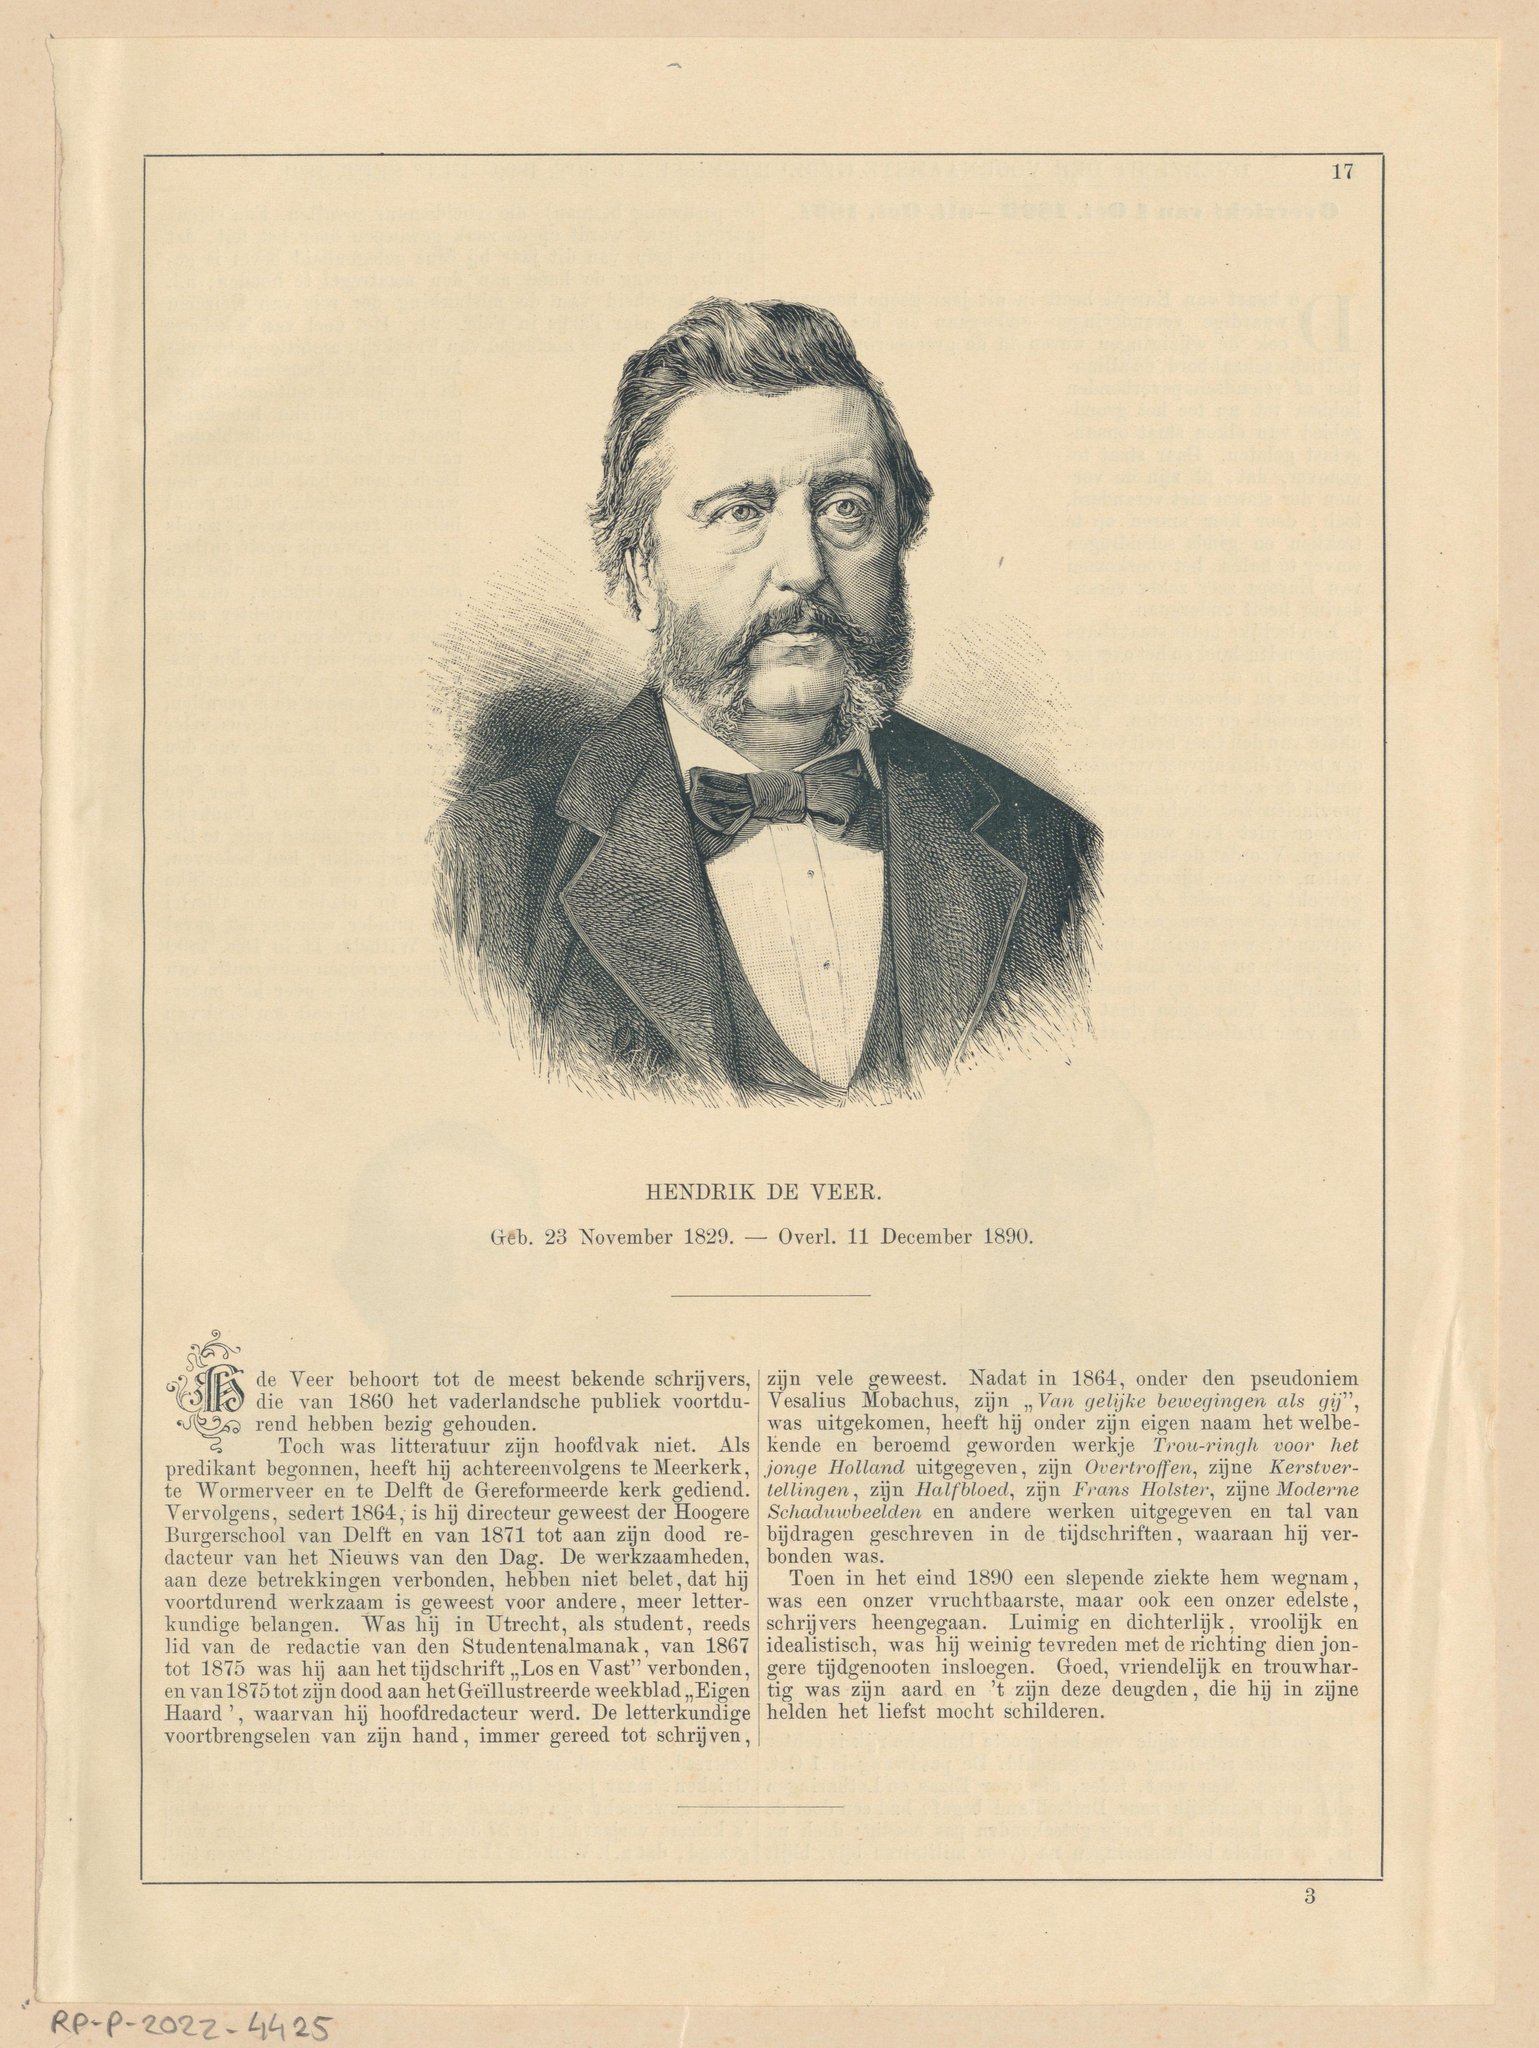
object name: print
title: Portret van Hendrik de Veer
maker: Anonymous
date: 1892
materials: paper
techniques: letterpress printing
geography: haarlem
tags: rhenen, historical persons, portrait of a writer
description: Prent uit: Nederlandsche Almanak voor 1892, p. 17.